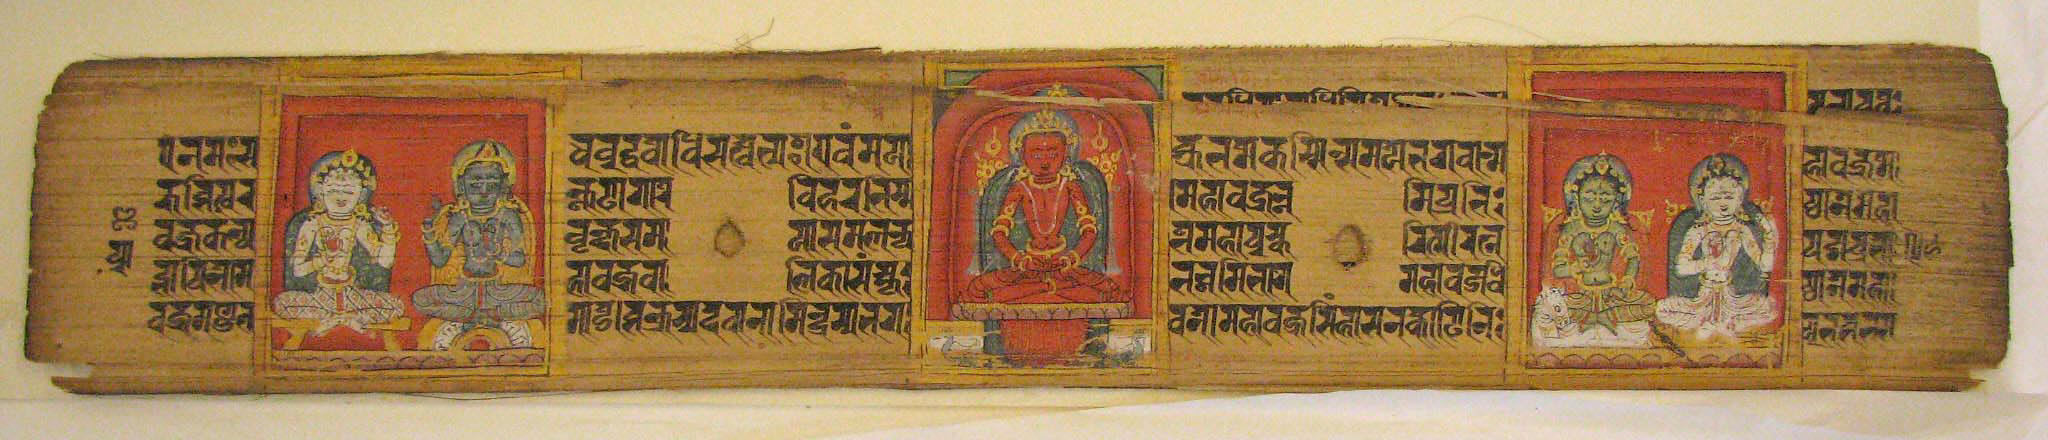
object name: folio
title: Leaf from an Illuminated Buddhist Manuscript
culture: nepali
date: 1301-1400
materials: ink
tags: buddhism,deities